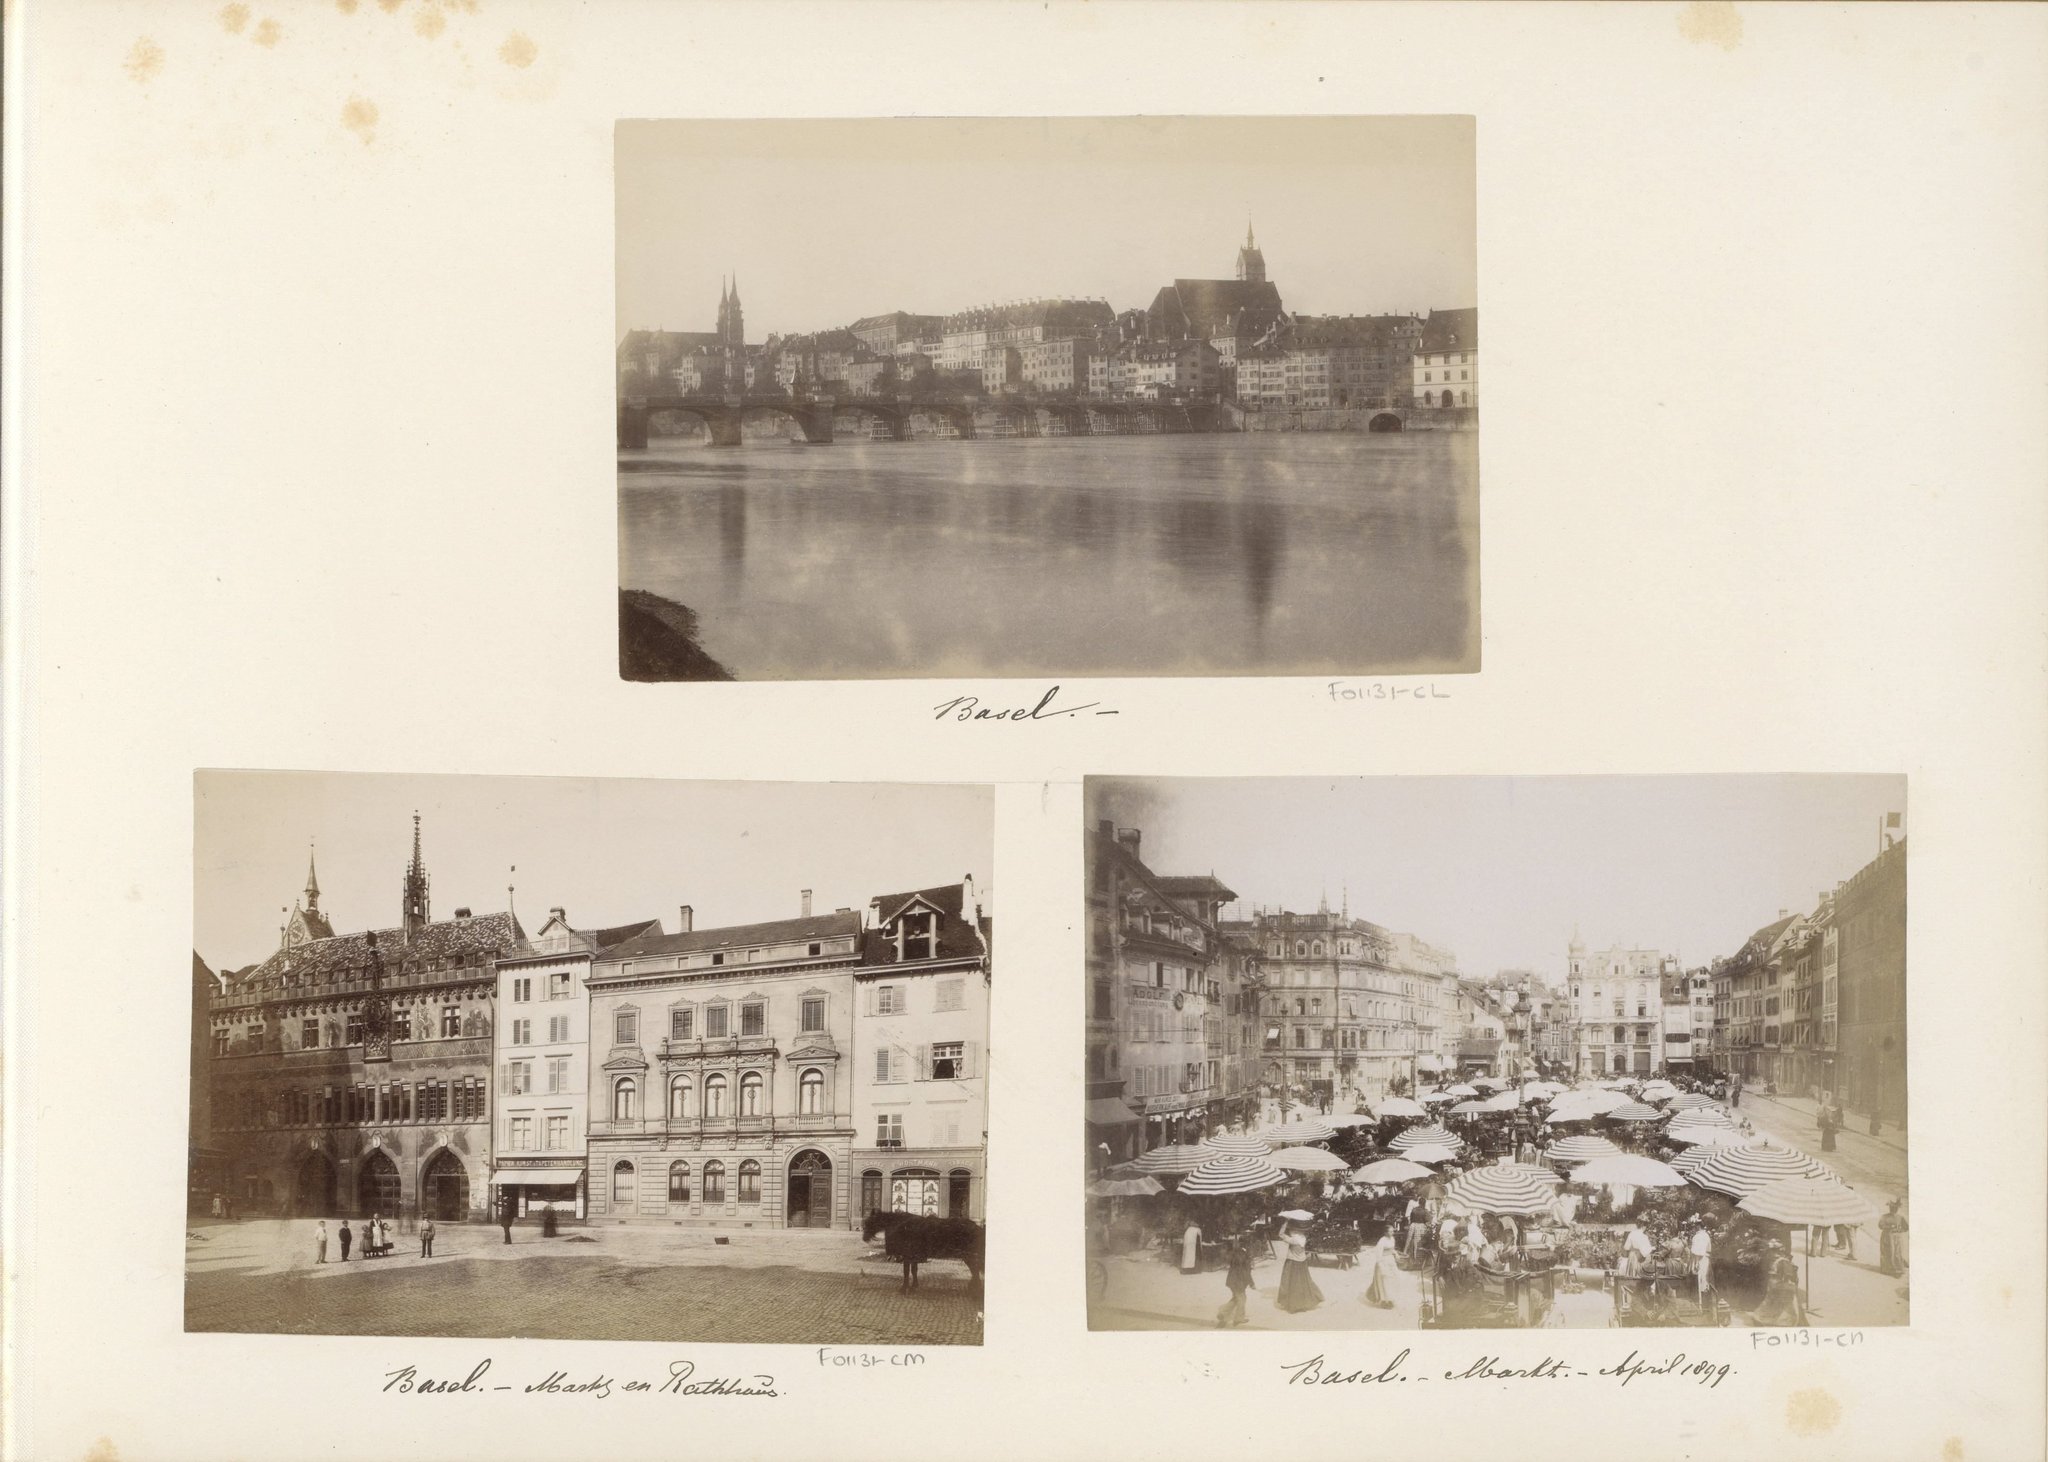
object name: photograph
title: Gezicht op Bazel met op de voorgrond de Rijn en de Alte Mittlere Brücke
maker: Anonymous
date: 1880-1899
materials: paper, photographic support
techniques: albumen print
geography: basel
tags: bridge in city across river, canal, etc., prospect of city, town panorama, silhouette of city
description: Onderdeel van Reisalbum met bezienswaardigheden in Duitsland, Oostenrijk, Zwitserland, Luxemburg en België.